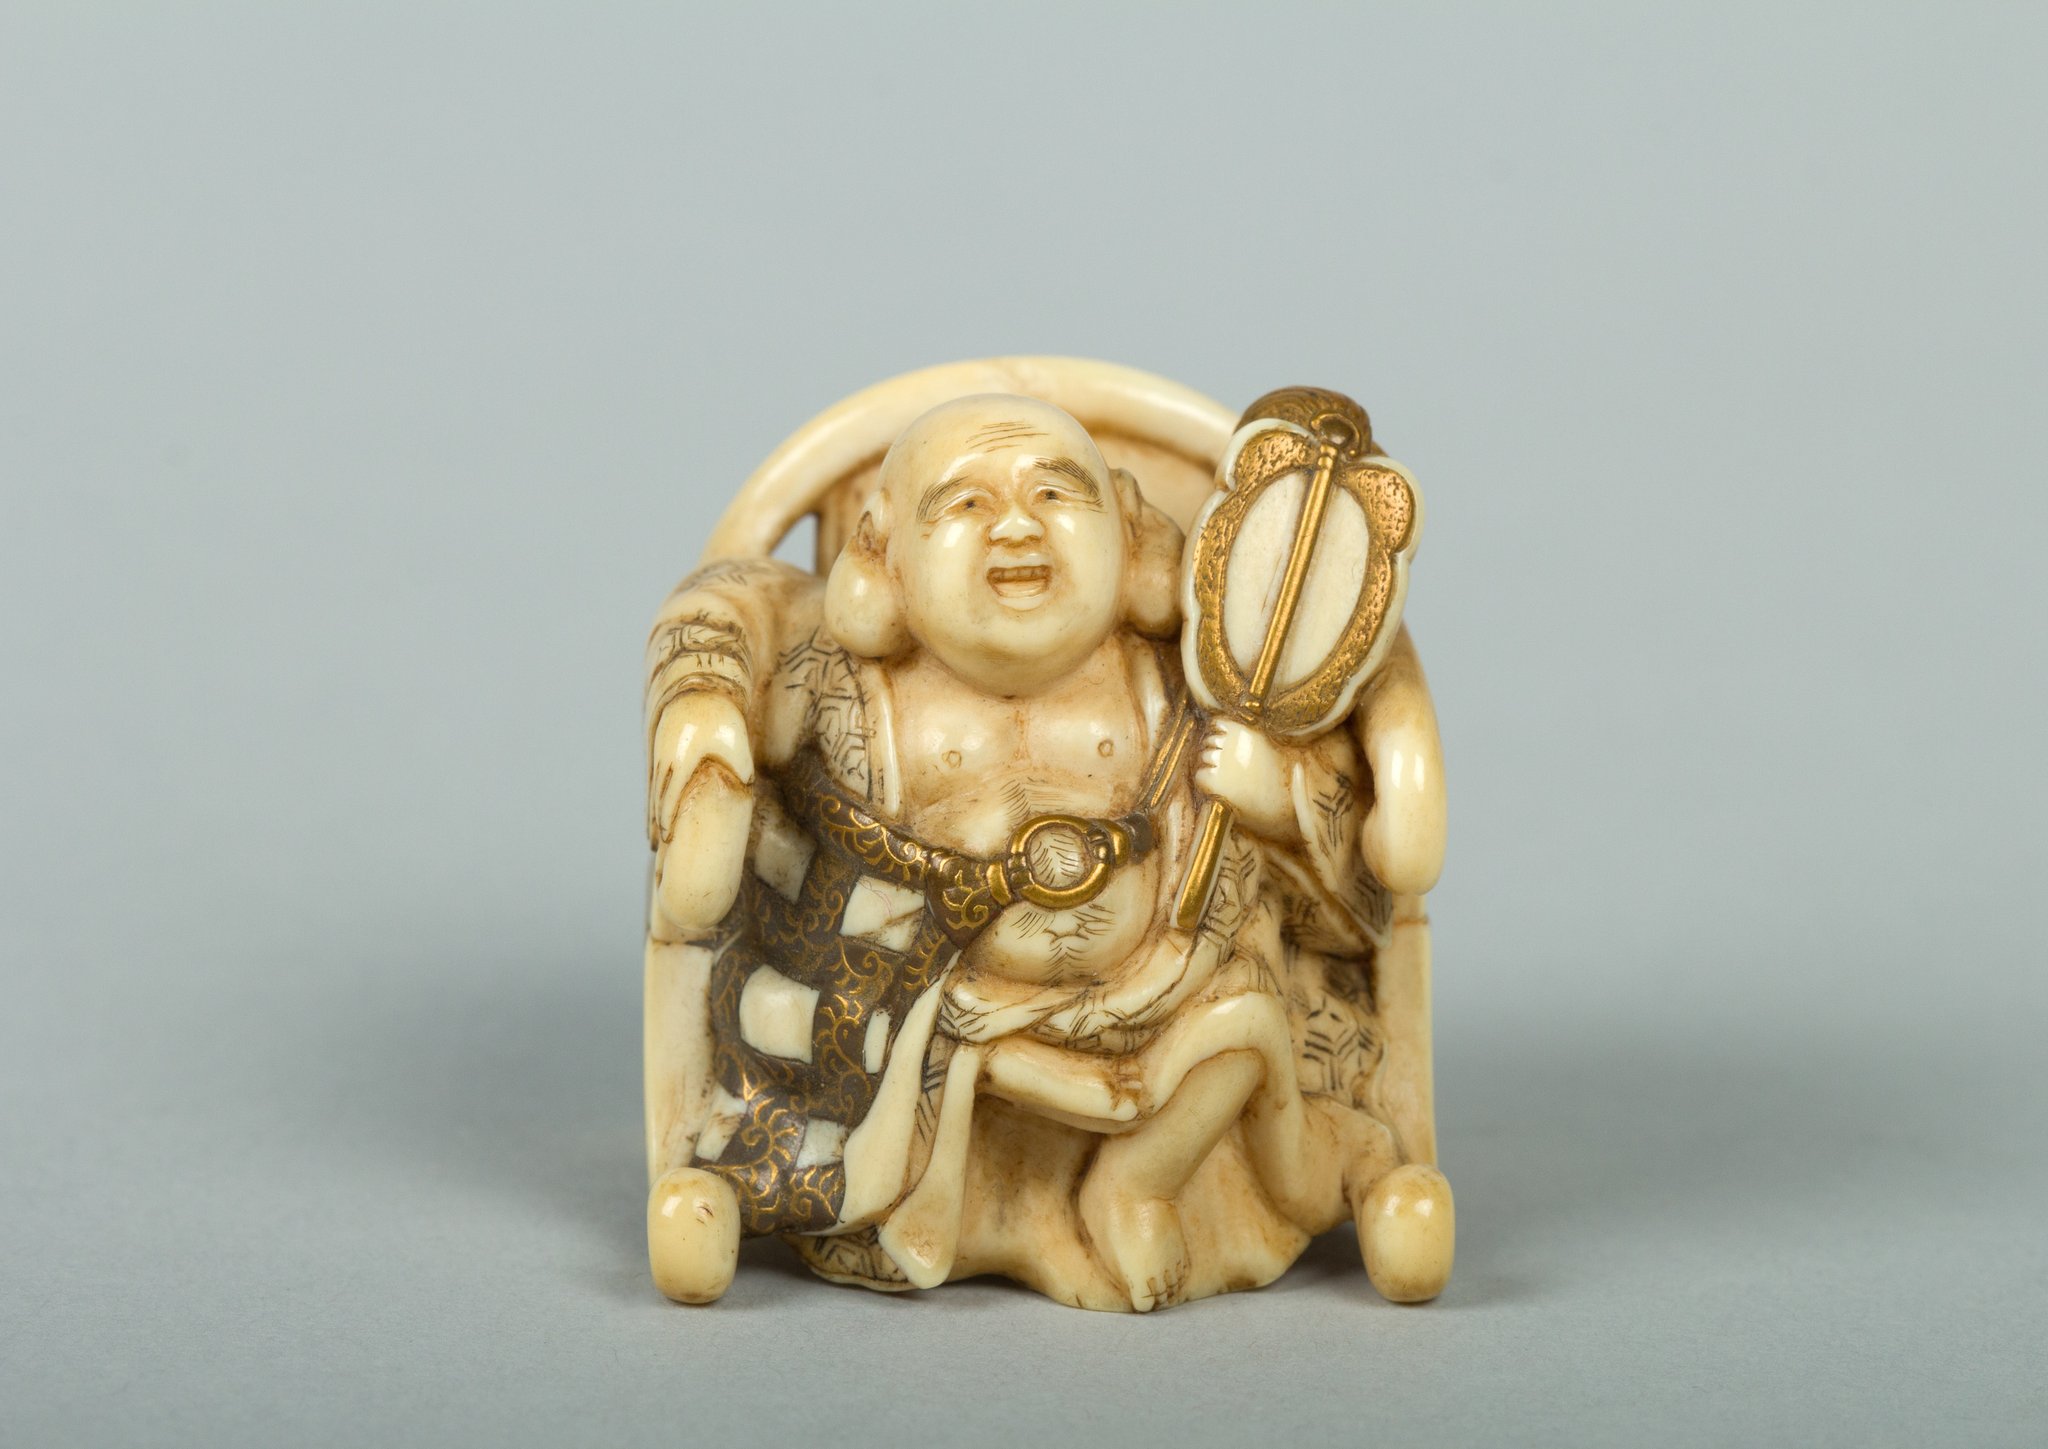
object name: netsuke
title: Netsuke of Hotei Seated in an Armchair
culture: japanese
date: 1801-1900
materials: ivory, lacquer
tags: men